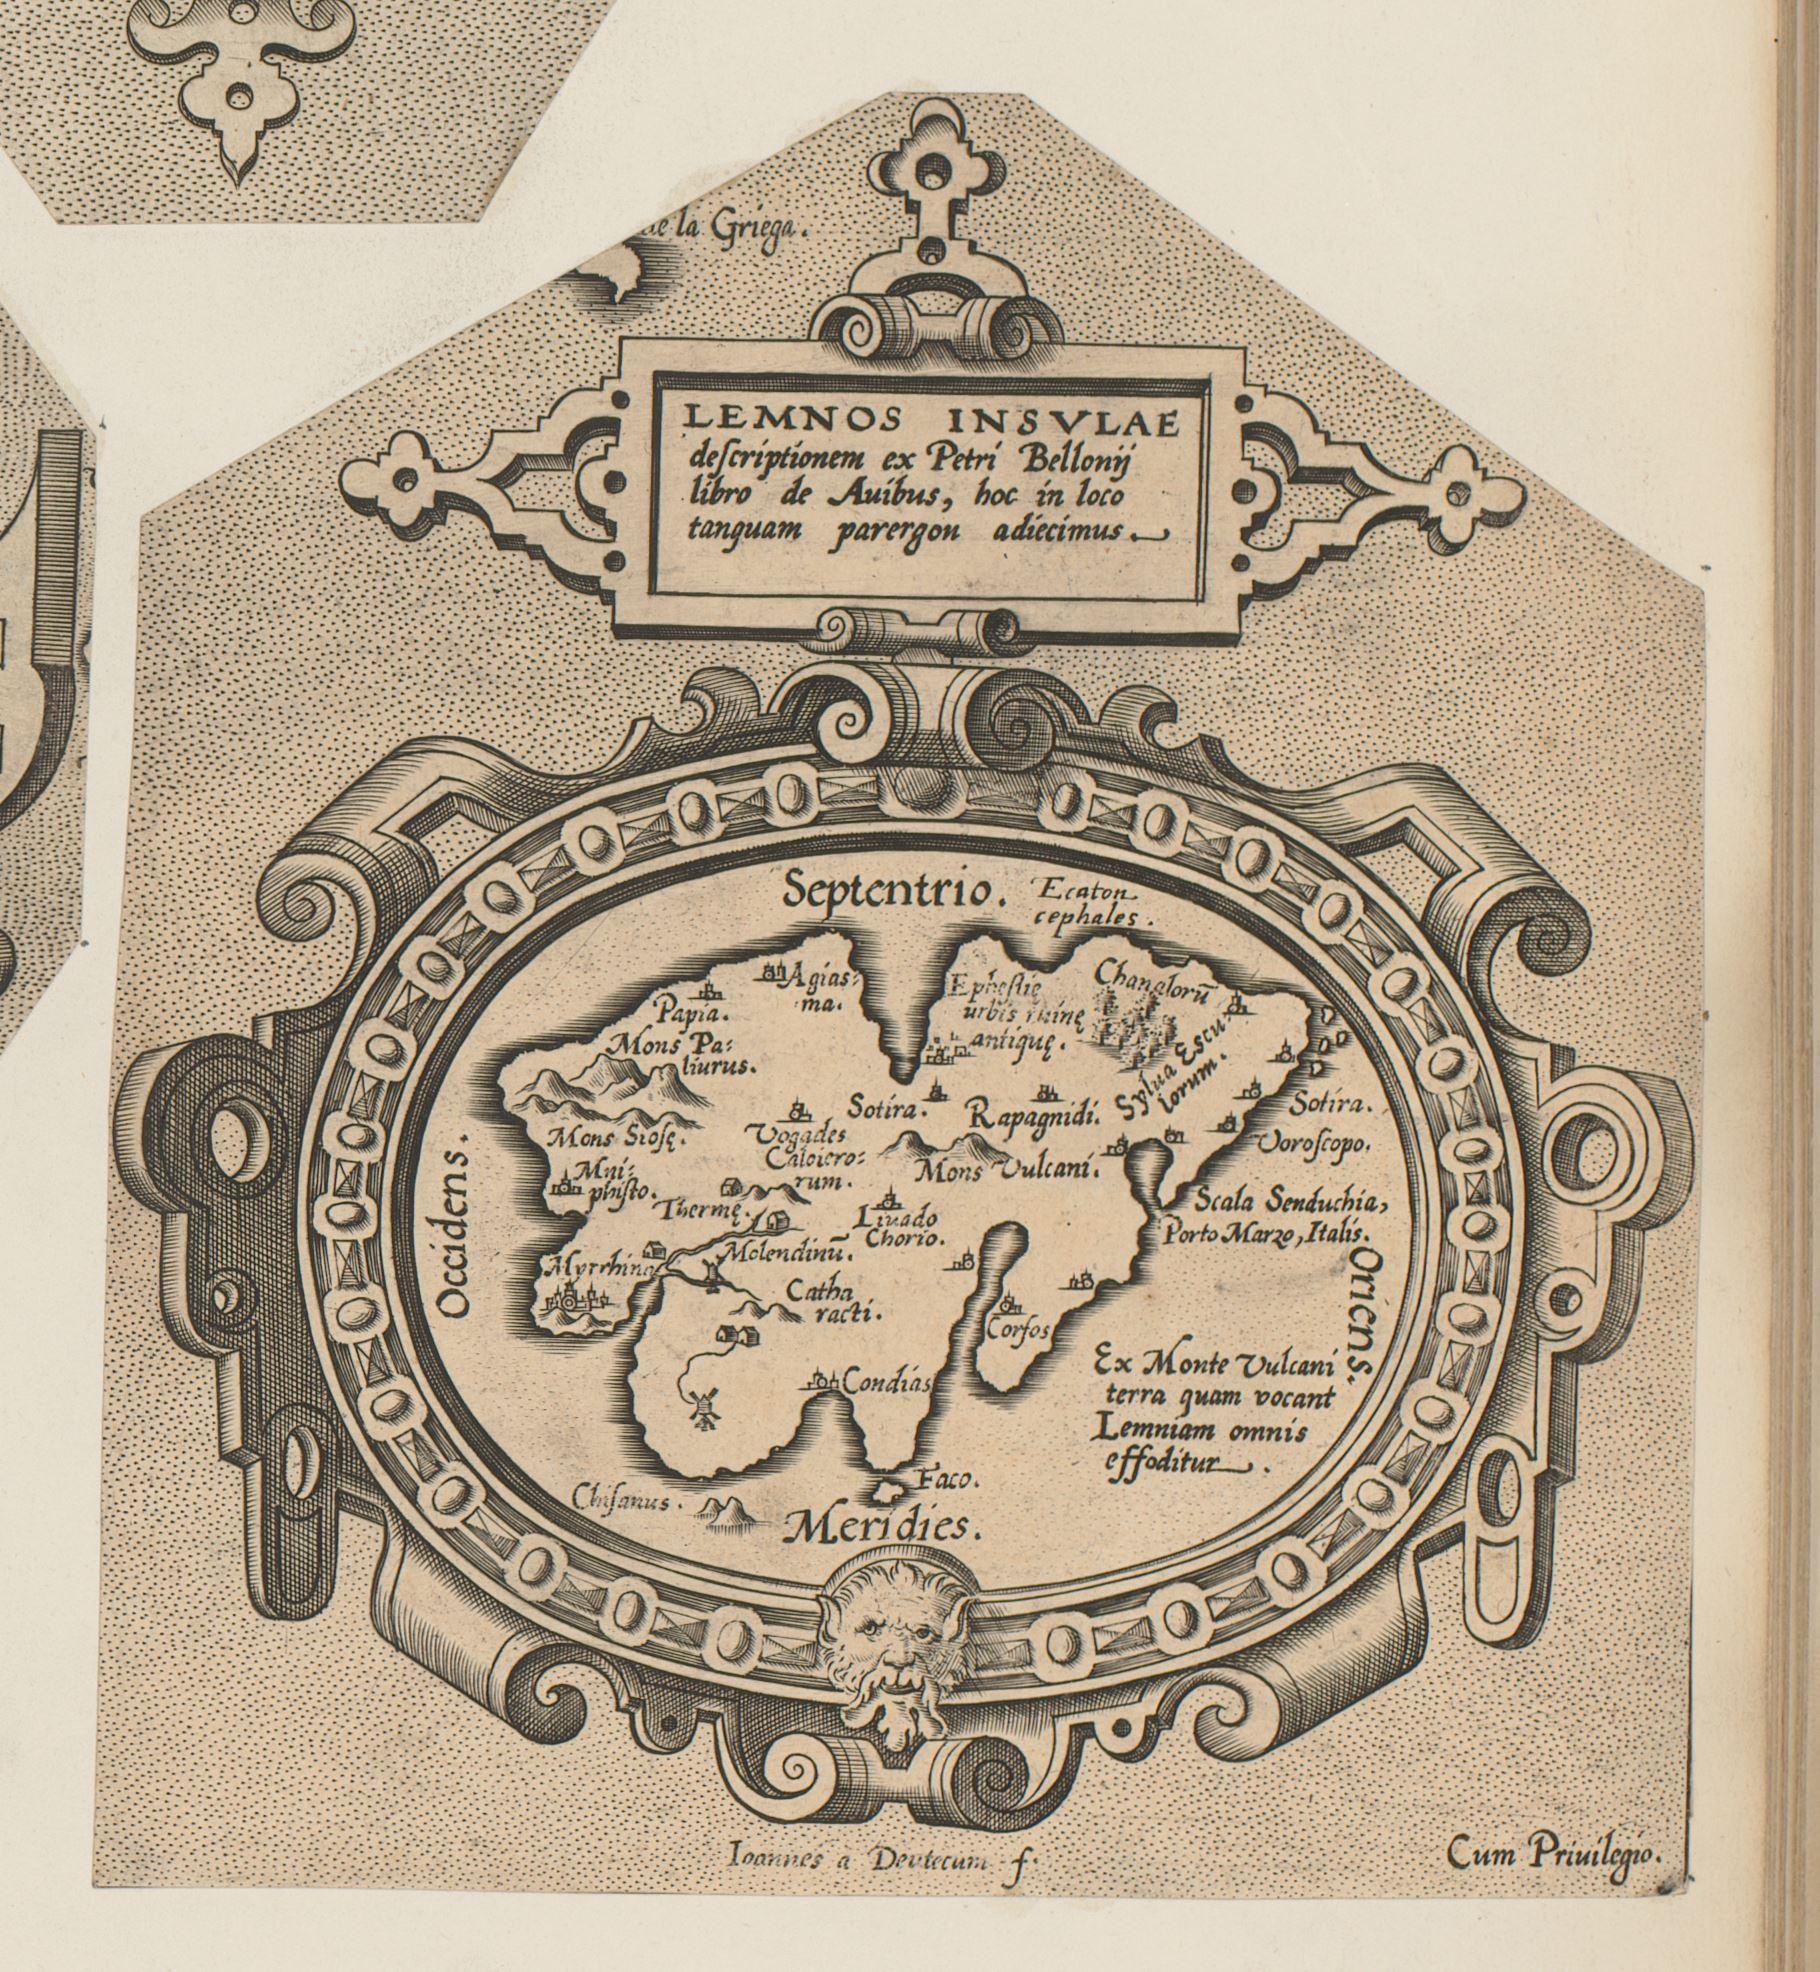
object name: album leaf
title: Theatrum Orbis Terrarum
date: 1572-1575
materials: paper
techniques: engraving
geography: antwerp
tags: maps, atlases, ornament ~ cartouche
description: Ovale liggende cartouche met een afbeelding van het eiland Lemnos. Midden boven een rechthoekig bord met de tekst: Lemnos Insulae ... De cartouche is een fragment van een kaart van Cyprus. De prent maakt deel uit van een album.